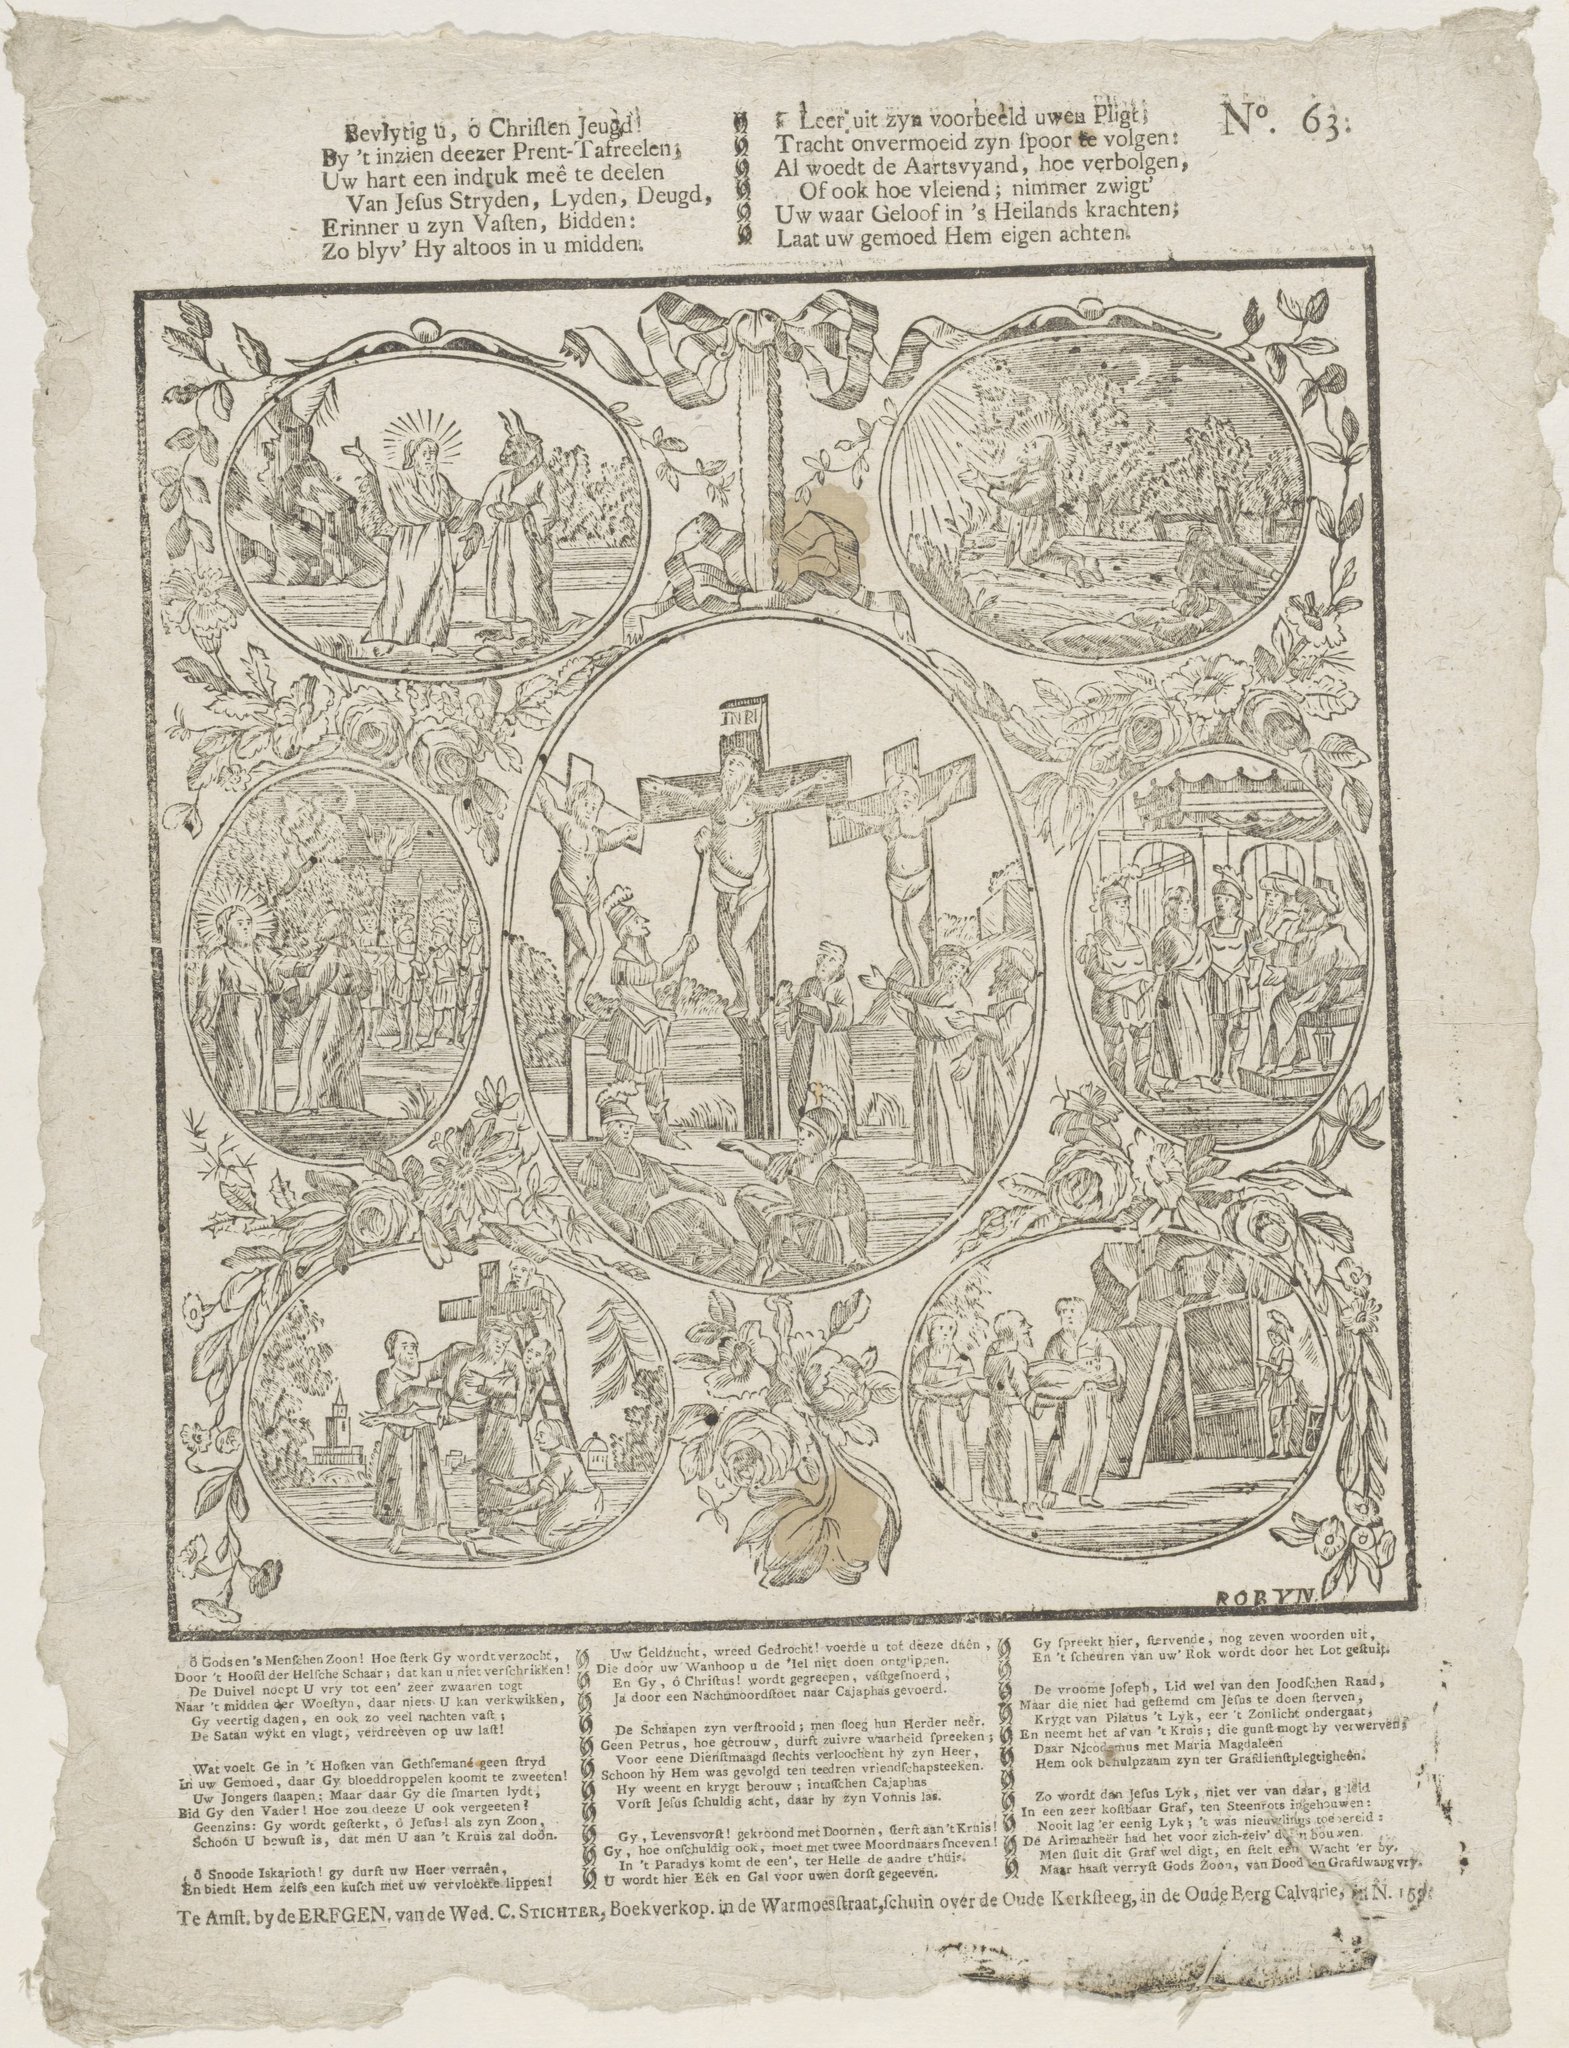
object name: popular print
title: Bevlytig u, o Christen jeugd! / By 't inzien deezer prent-tafreelen [(...)]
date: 1797-1813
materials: paper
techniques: letterpress printing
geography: amsterdam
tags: new testament, series of scenes from the life of christ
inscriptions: collector's mark: Lugt 2760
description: Blad met 7 medaillons met scènes uit het leven van Christus, zoals de Kruisiging van Christus en de Kruisafname. De voorstellingen zijn aan elkaar verbonden met linten en bloemenranken. Het geheel is gevat in een kader. Onder de afbeelding een vers in drie kolommen. Genummerd rechtsboven: No. 63.